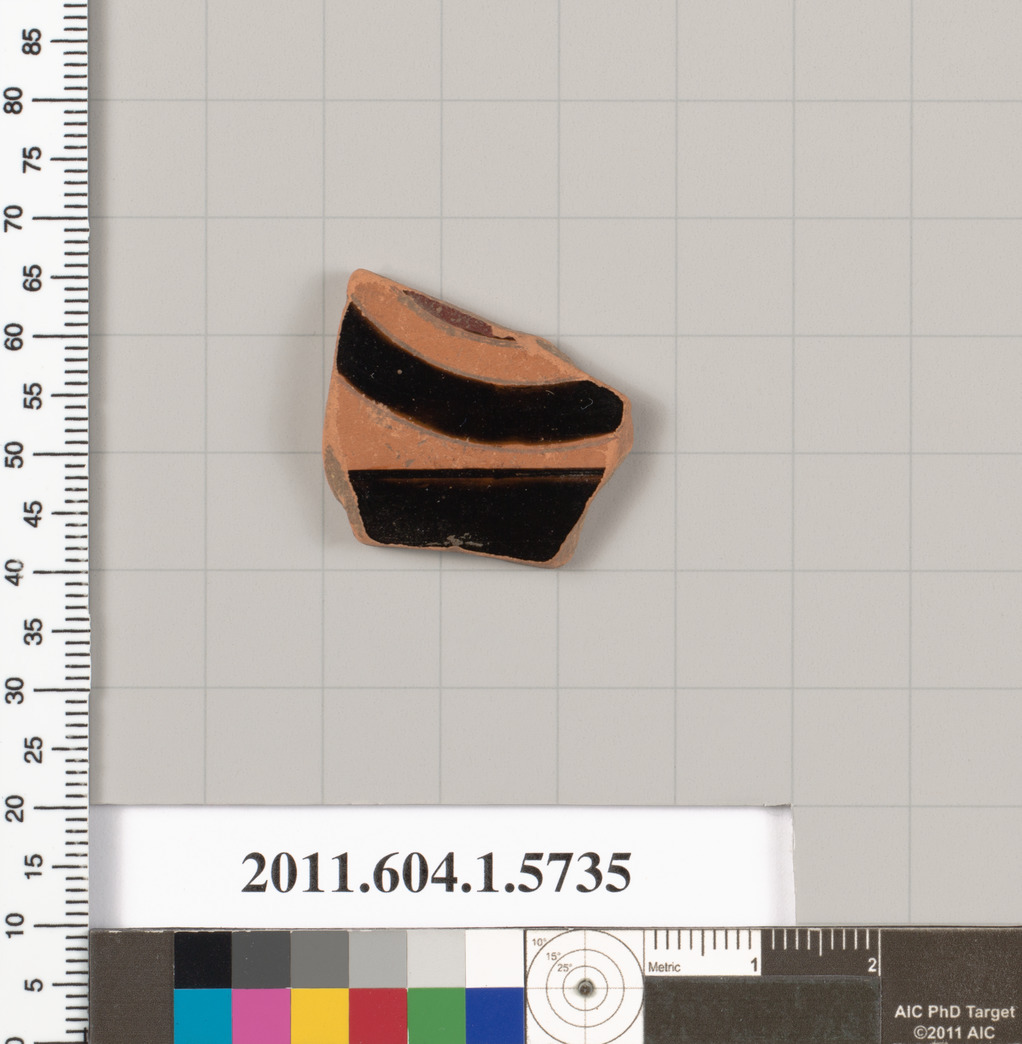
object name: kylix fragment, eye cup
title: Terracotta fragment of a kylix: eye-cup (drinking cup)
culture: greek, attic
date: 525-515 BCE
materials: terracotta